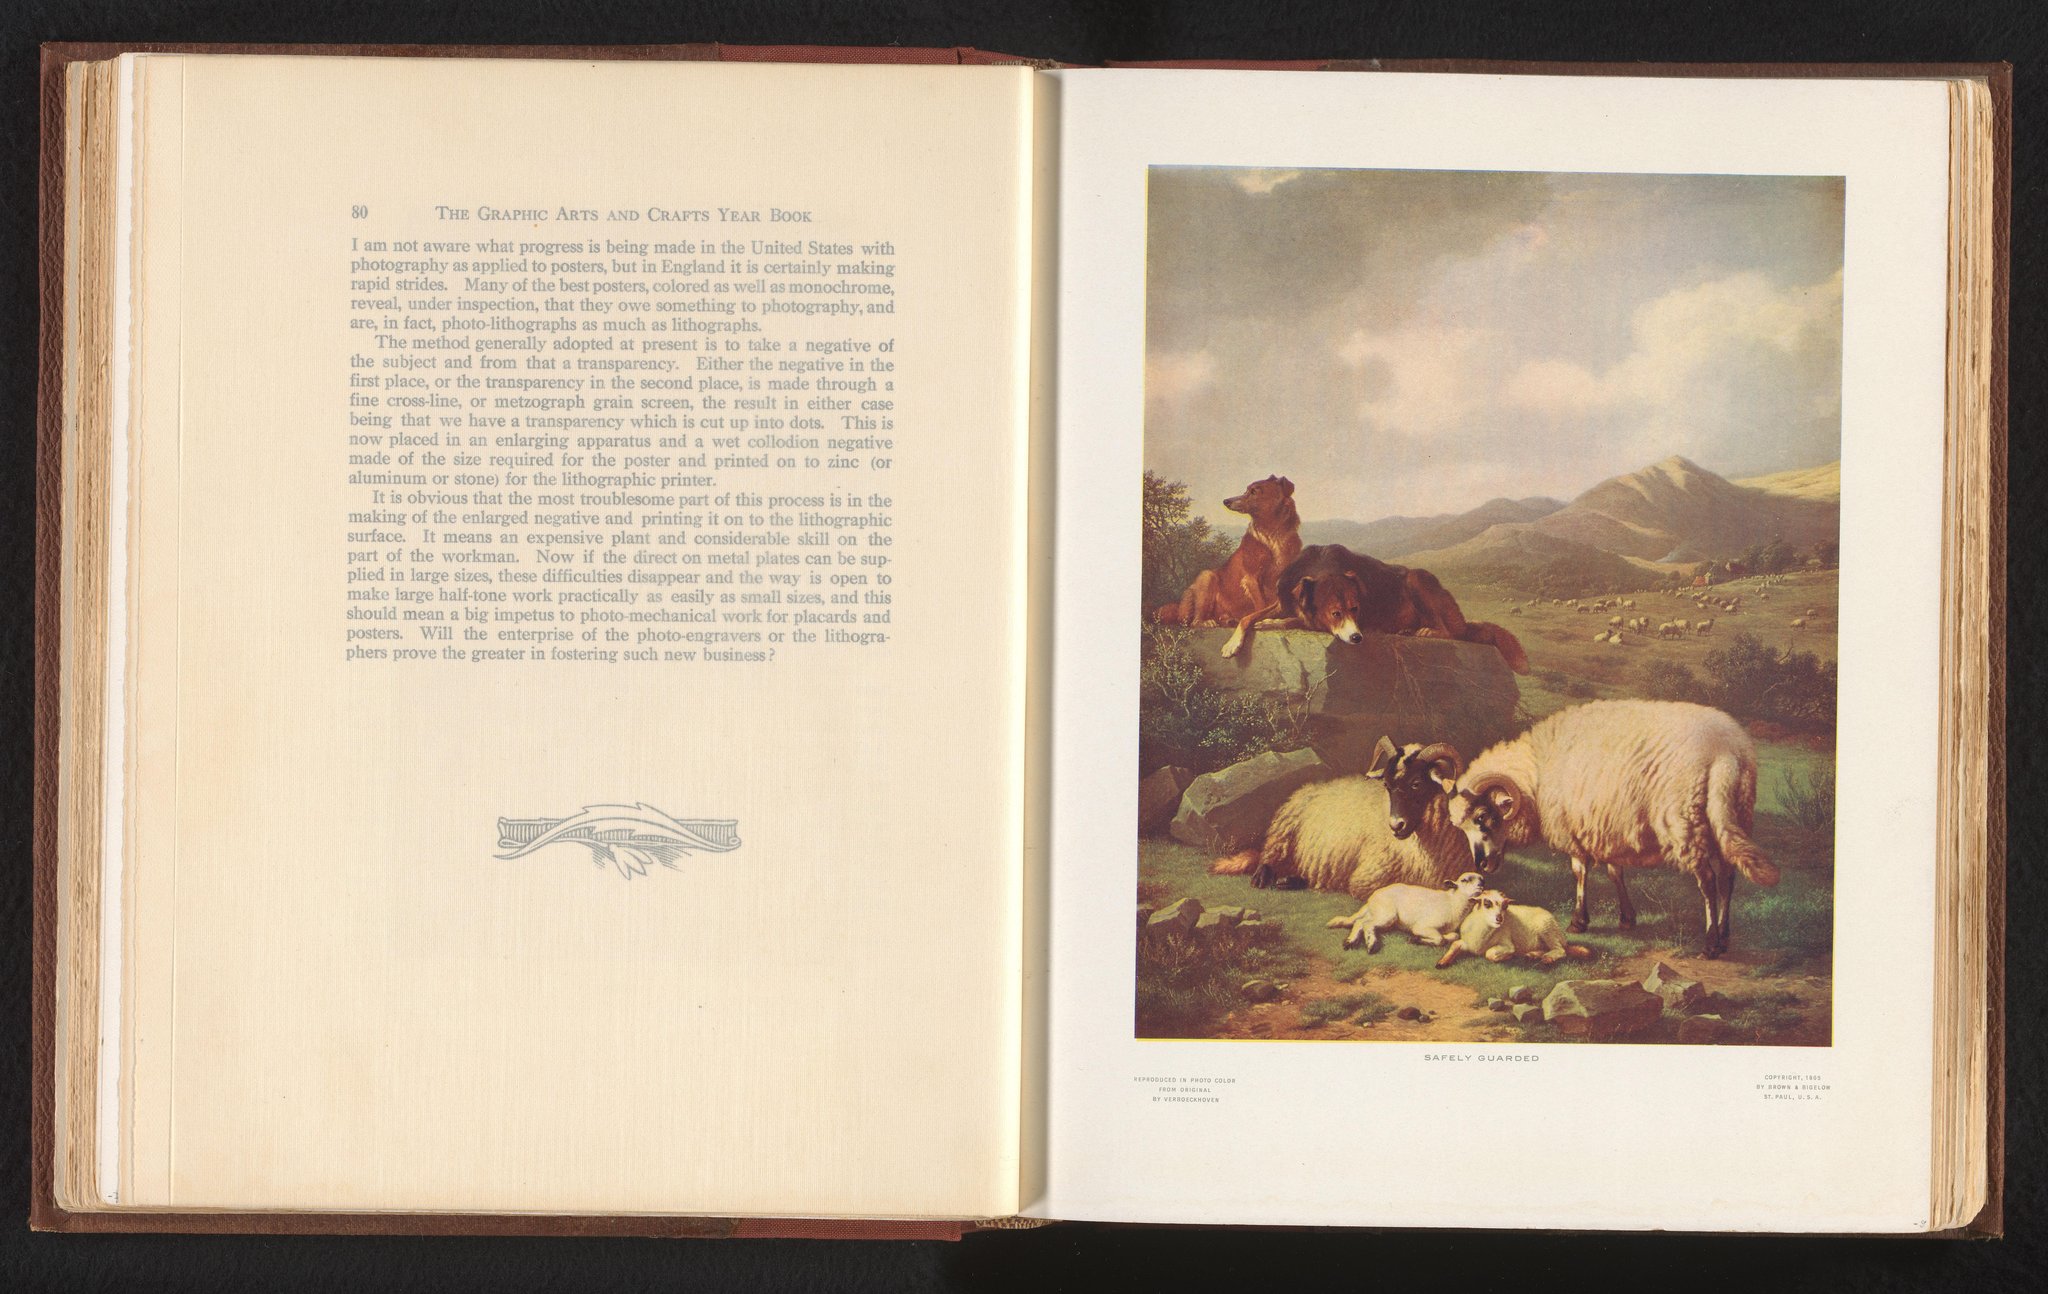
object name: photomechanical print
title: Safely Guarded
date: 1904-1909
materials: paper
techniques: three-color autotype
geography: saint paul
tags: low hill country, sheep, dog